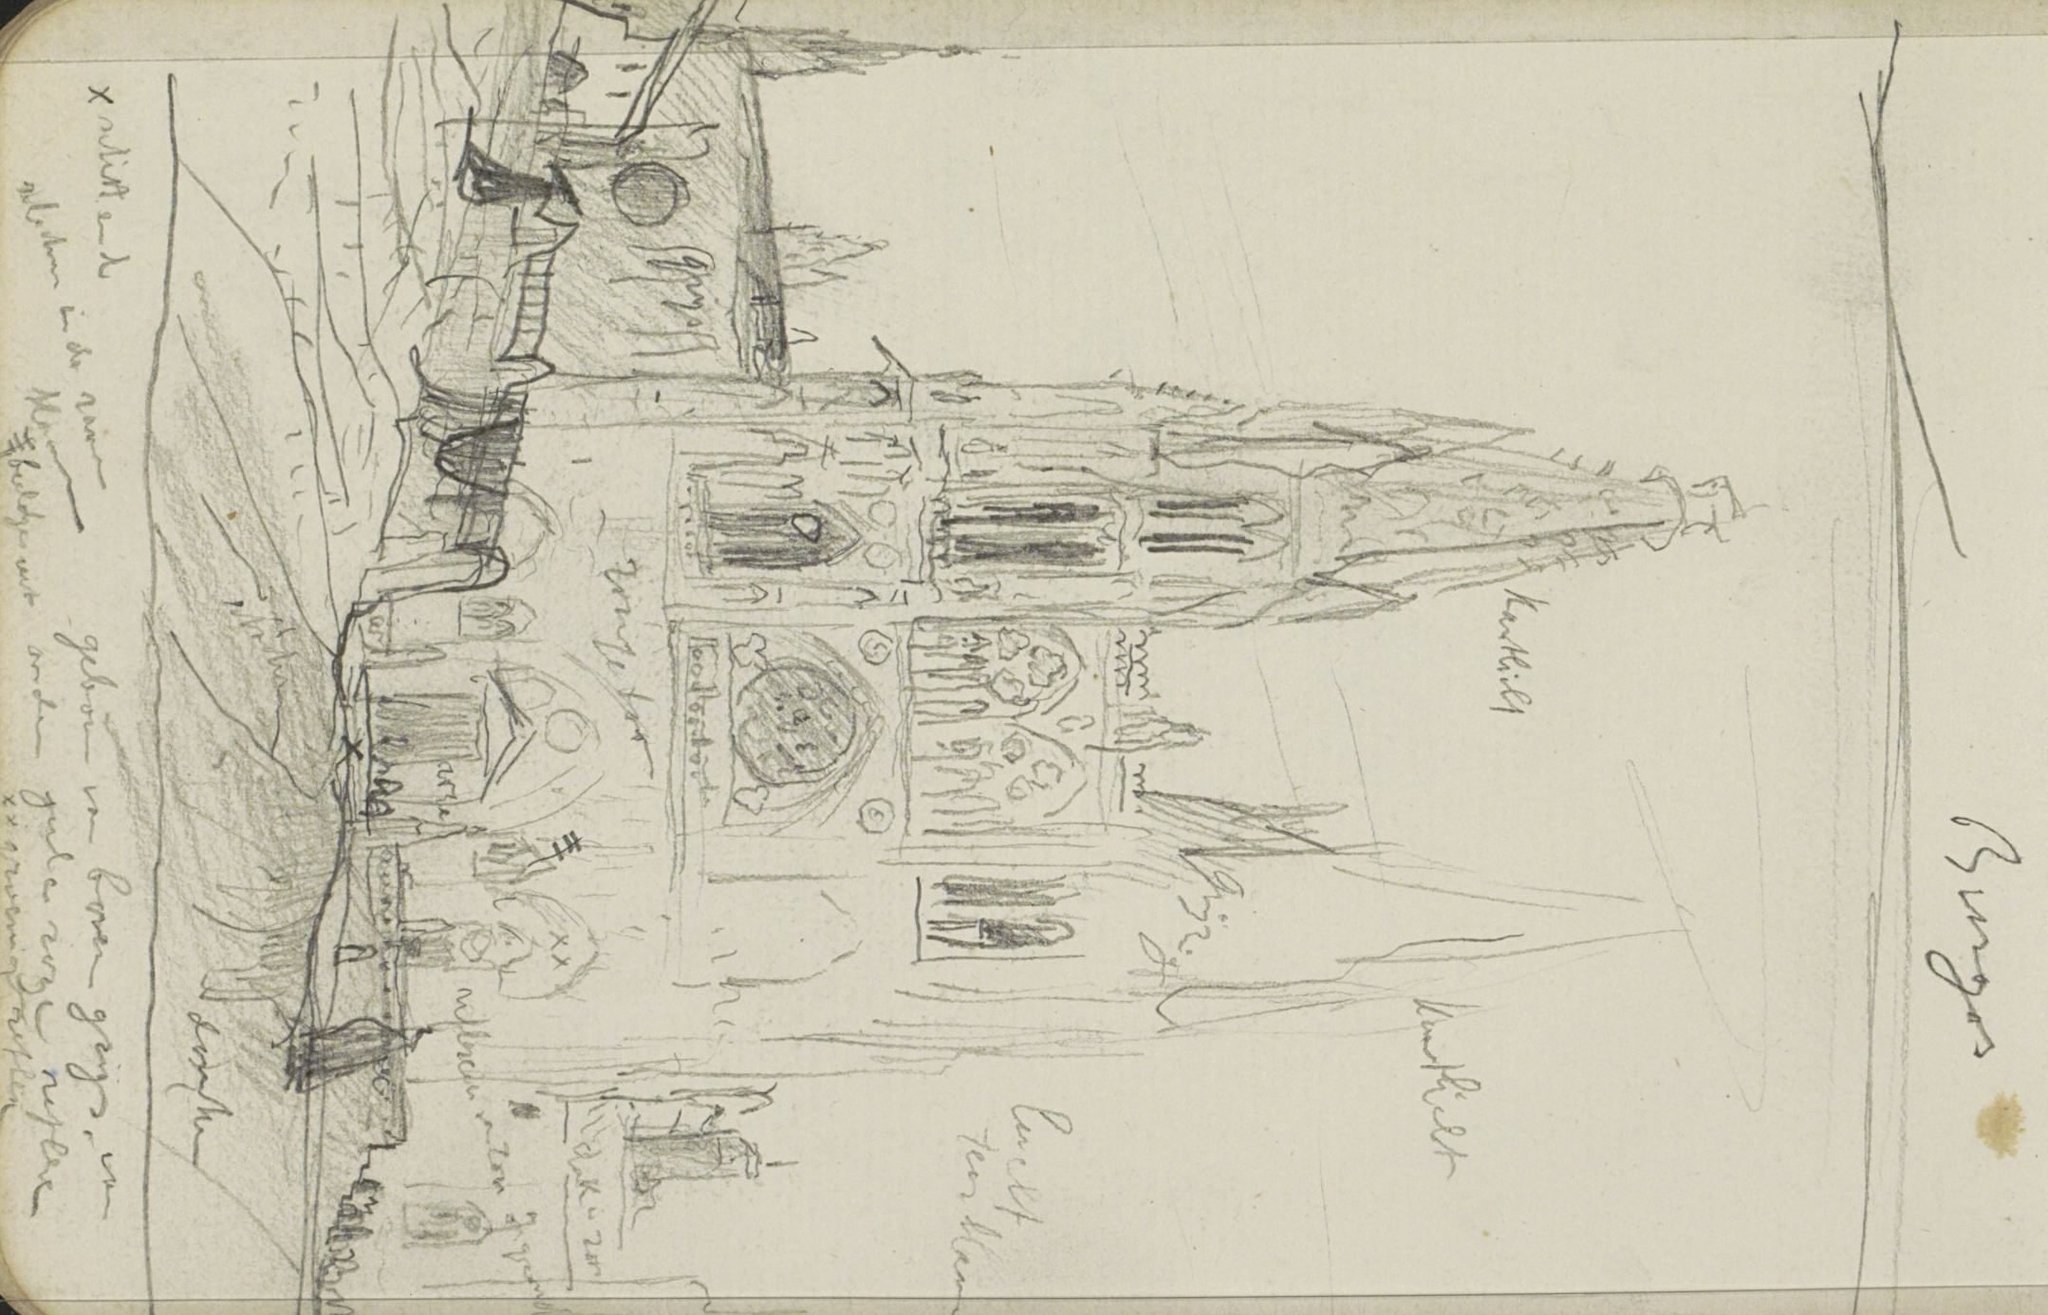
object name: sketchbook leaf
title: Vooraanzicht van de kathedraal van Burgos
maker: marius bauer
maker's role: draughtsman, print maker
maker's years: 1867-1932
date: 1902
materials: paper, pencil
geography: burgos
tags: church (exterior)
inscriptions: annotation: ‘Burgos’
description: Pagina 44 uit een schetsboek met 30 bladen.